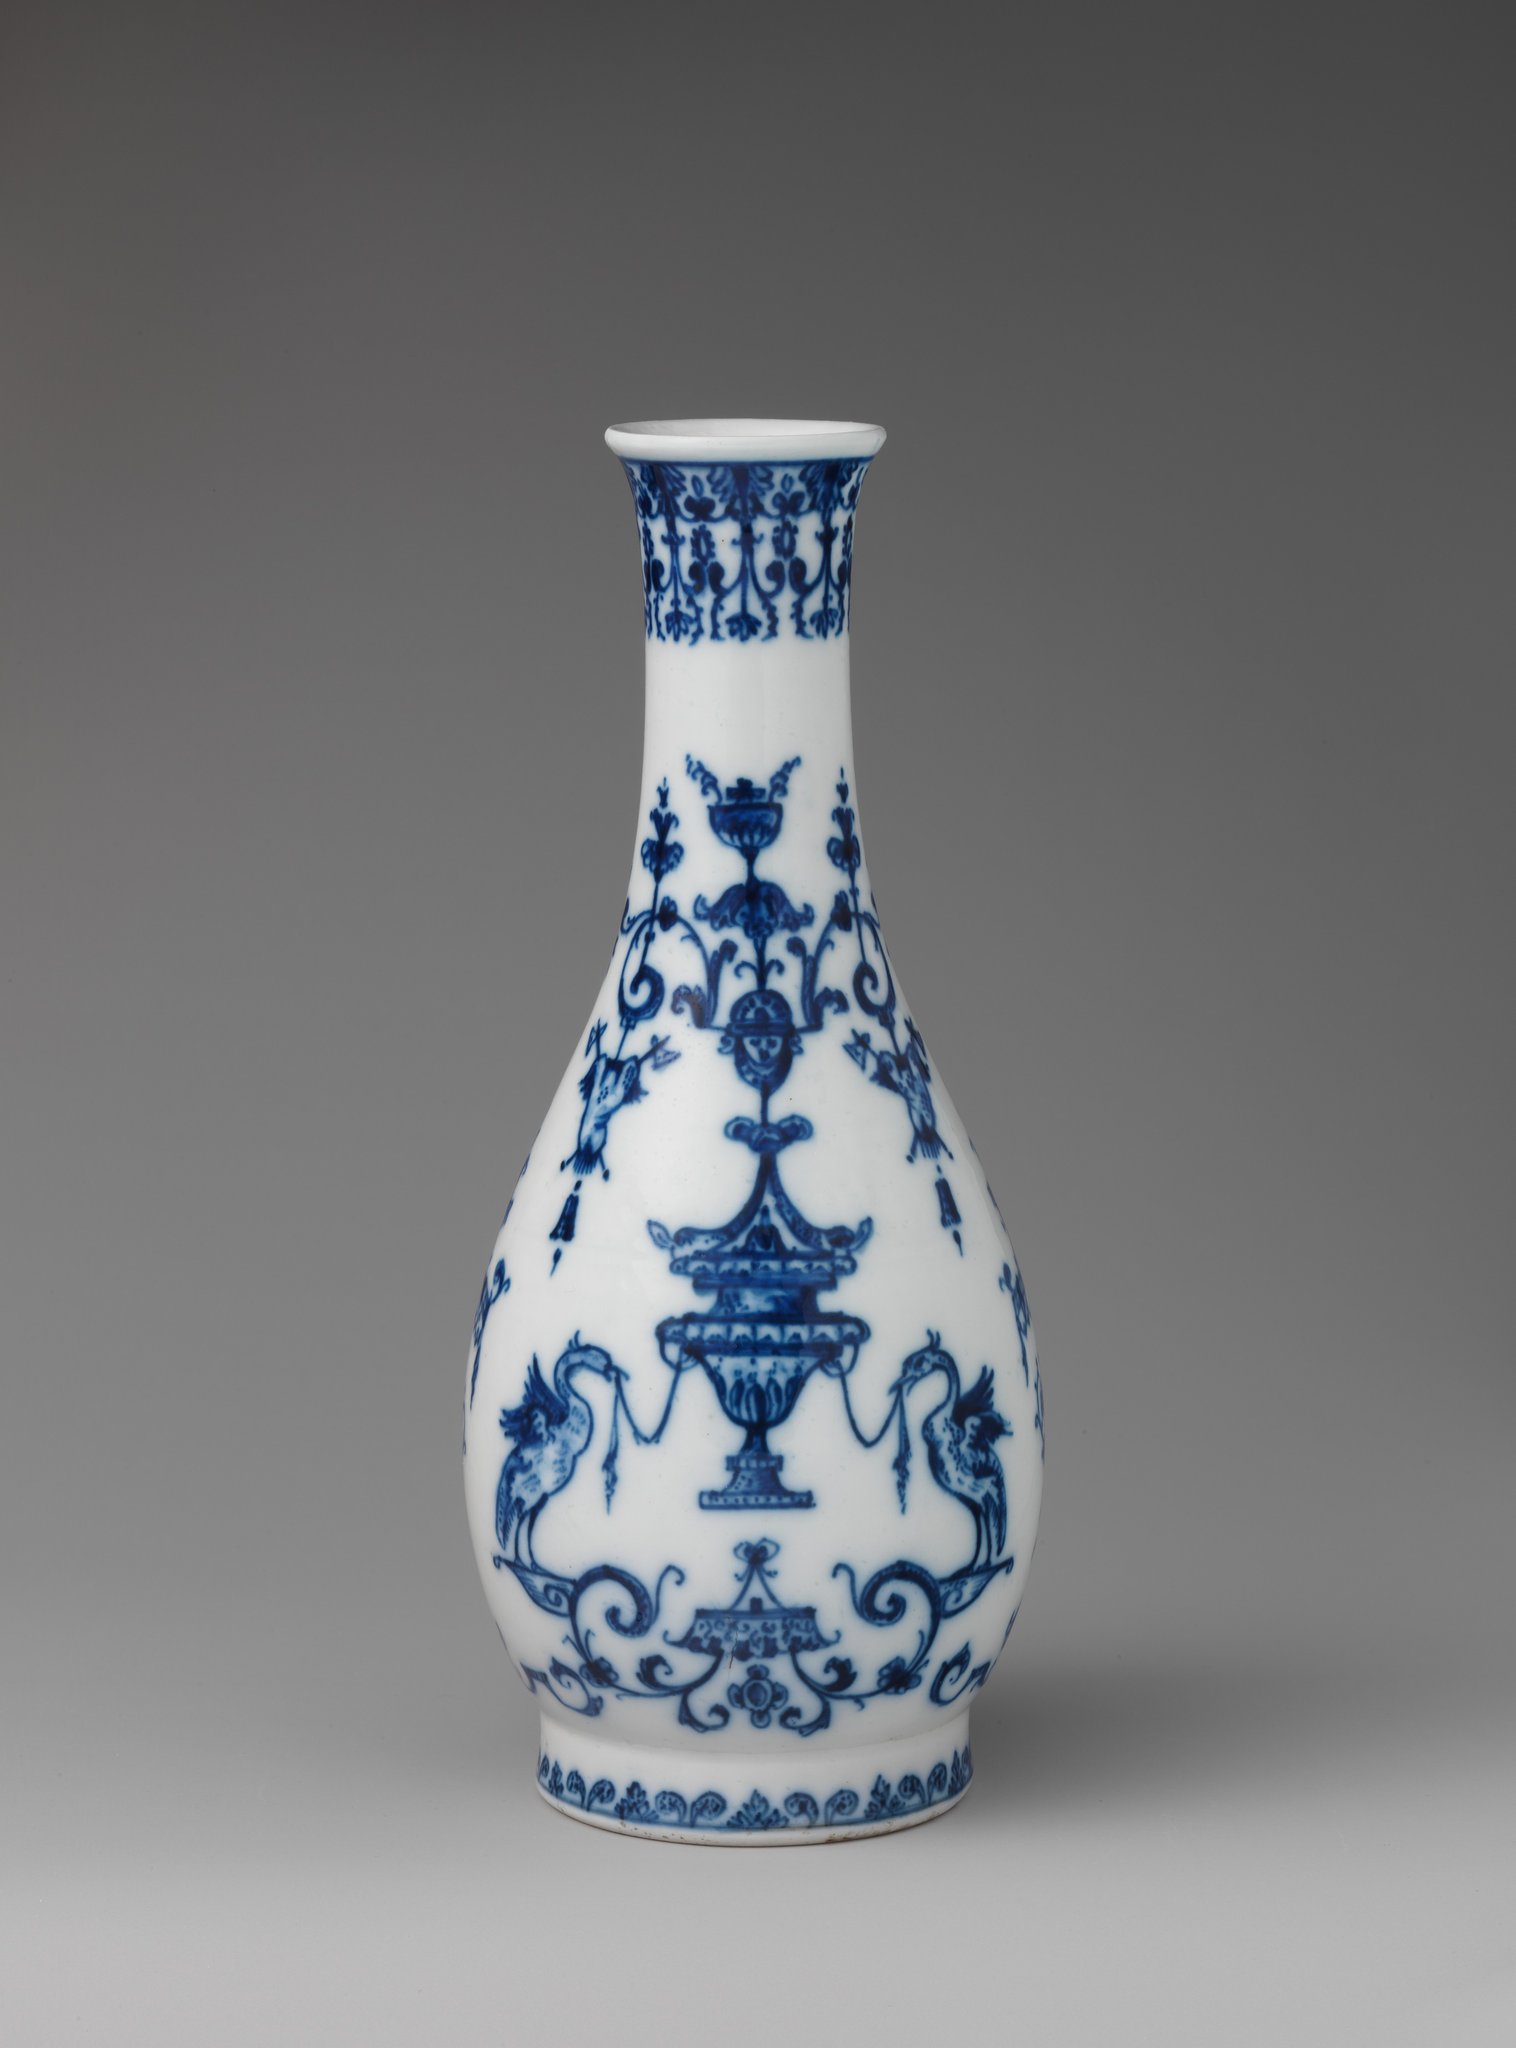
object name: bottle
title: Bottle with arabesque designs (one of a pair)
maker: saint-cloud factory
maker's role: factory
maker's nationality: french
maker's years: 1693-1766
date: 1695-1700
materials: soft paste porcelain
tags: birds